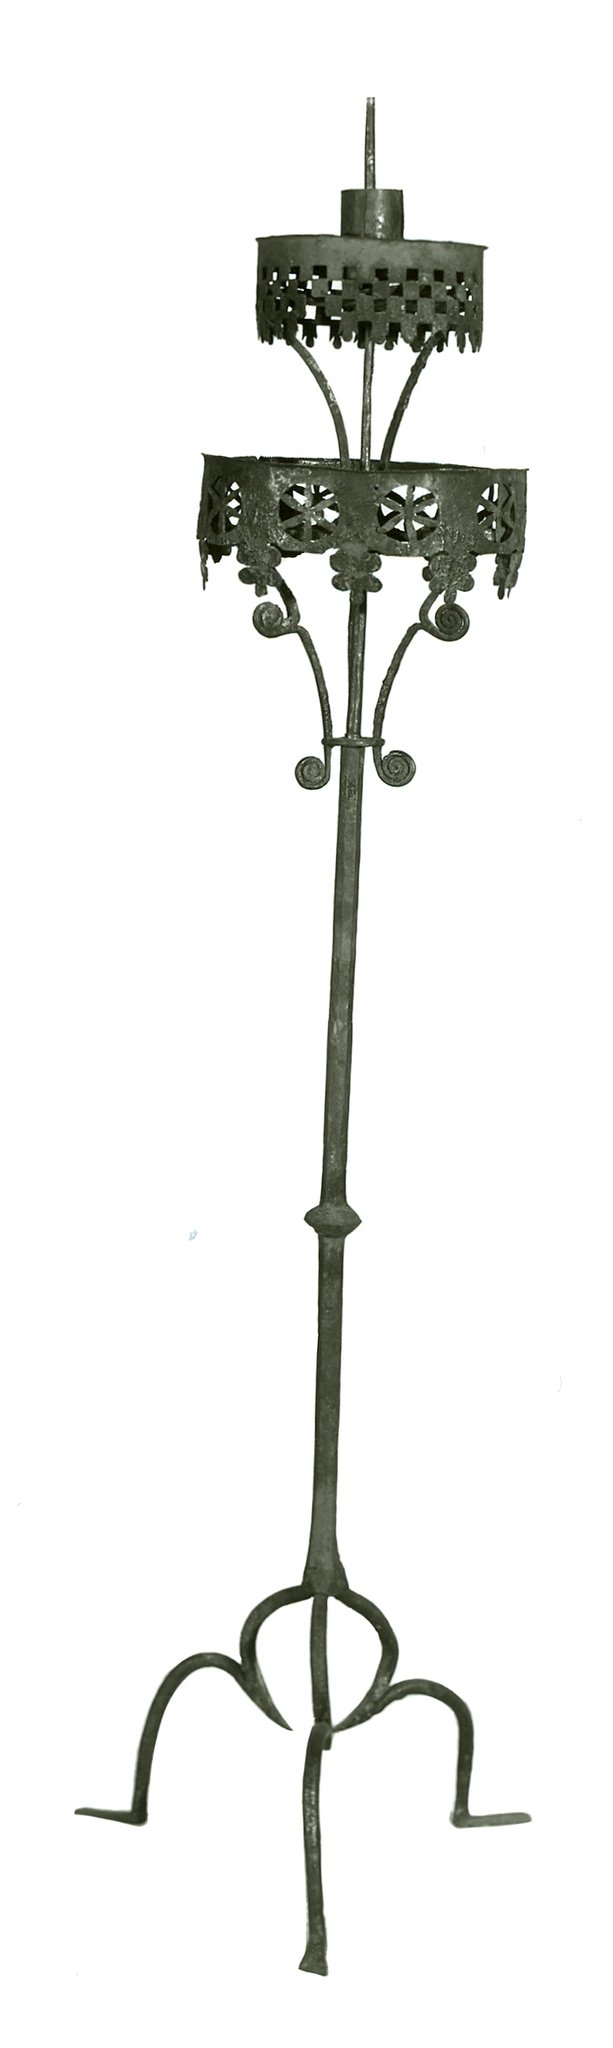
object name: candlestick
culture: french or spanish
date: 1401-1500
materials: iron